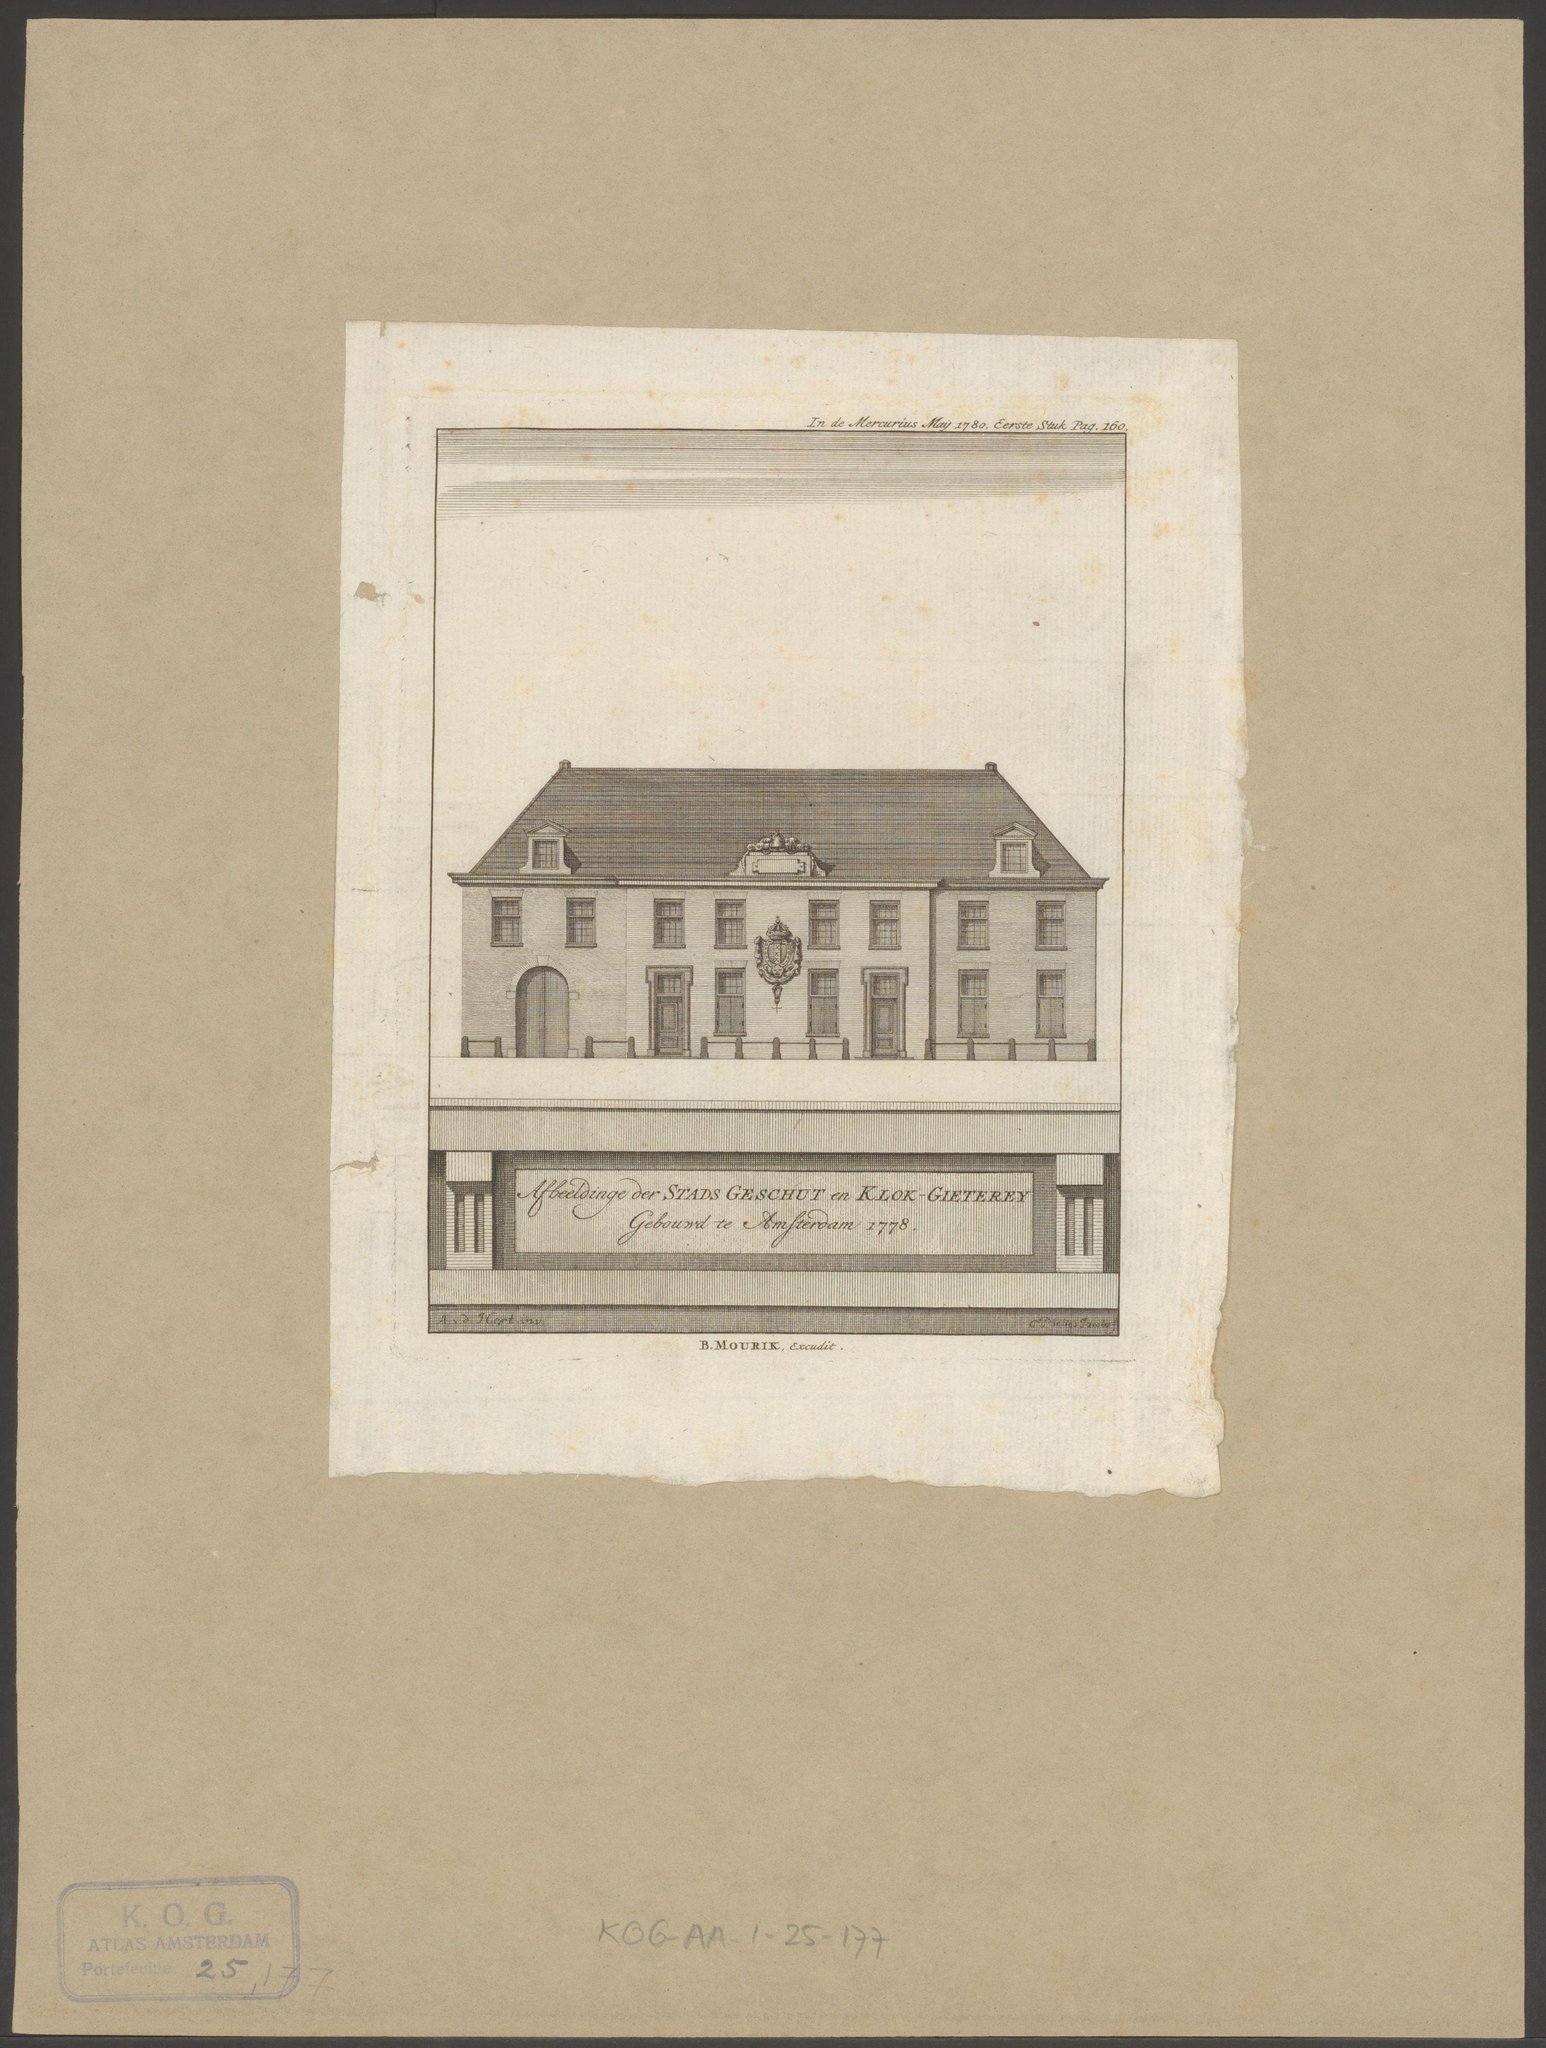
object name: print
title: Afbeeldinge der Stads Geschut en Klok-Gietery Gebouwd te Amsterdam 1778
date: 1788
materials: paper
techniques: etching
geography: amsterdam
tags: civic architecture; edifices; dwellings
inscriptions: collector's mark: ‘25.177’ Lugt 1641b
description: Rechtsboven gemarkeerd: In de Mercurius May 1780. Eerste Stuk Pag. 160. Onderwerpsrubriek binnen de Atlas Amsterdam: Krijgswezen I: De Admiraliteit van Amsterdam, E. Doelen en Wachthuizen.